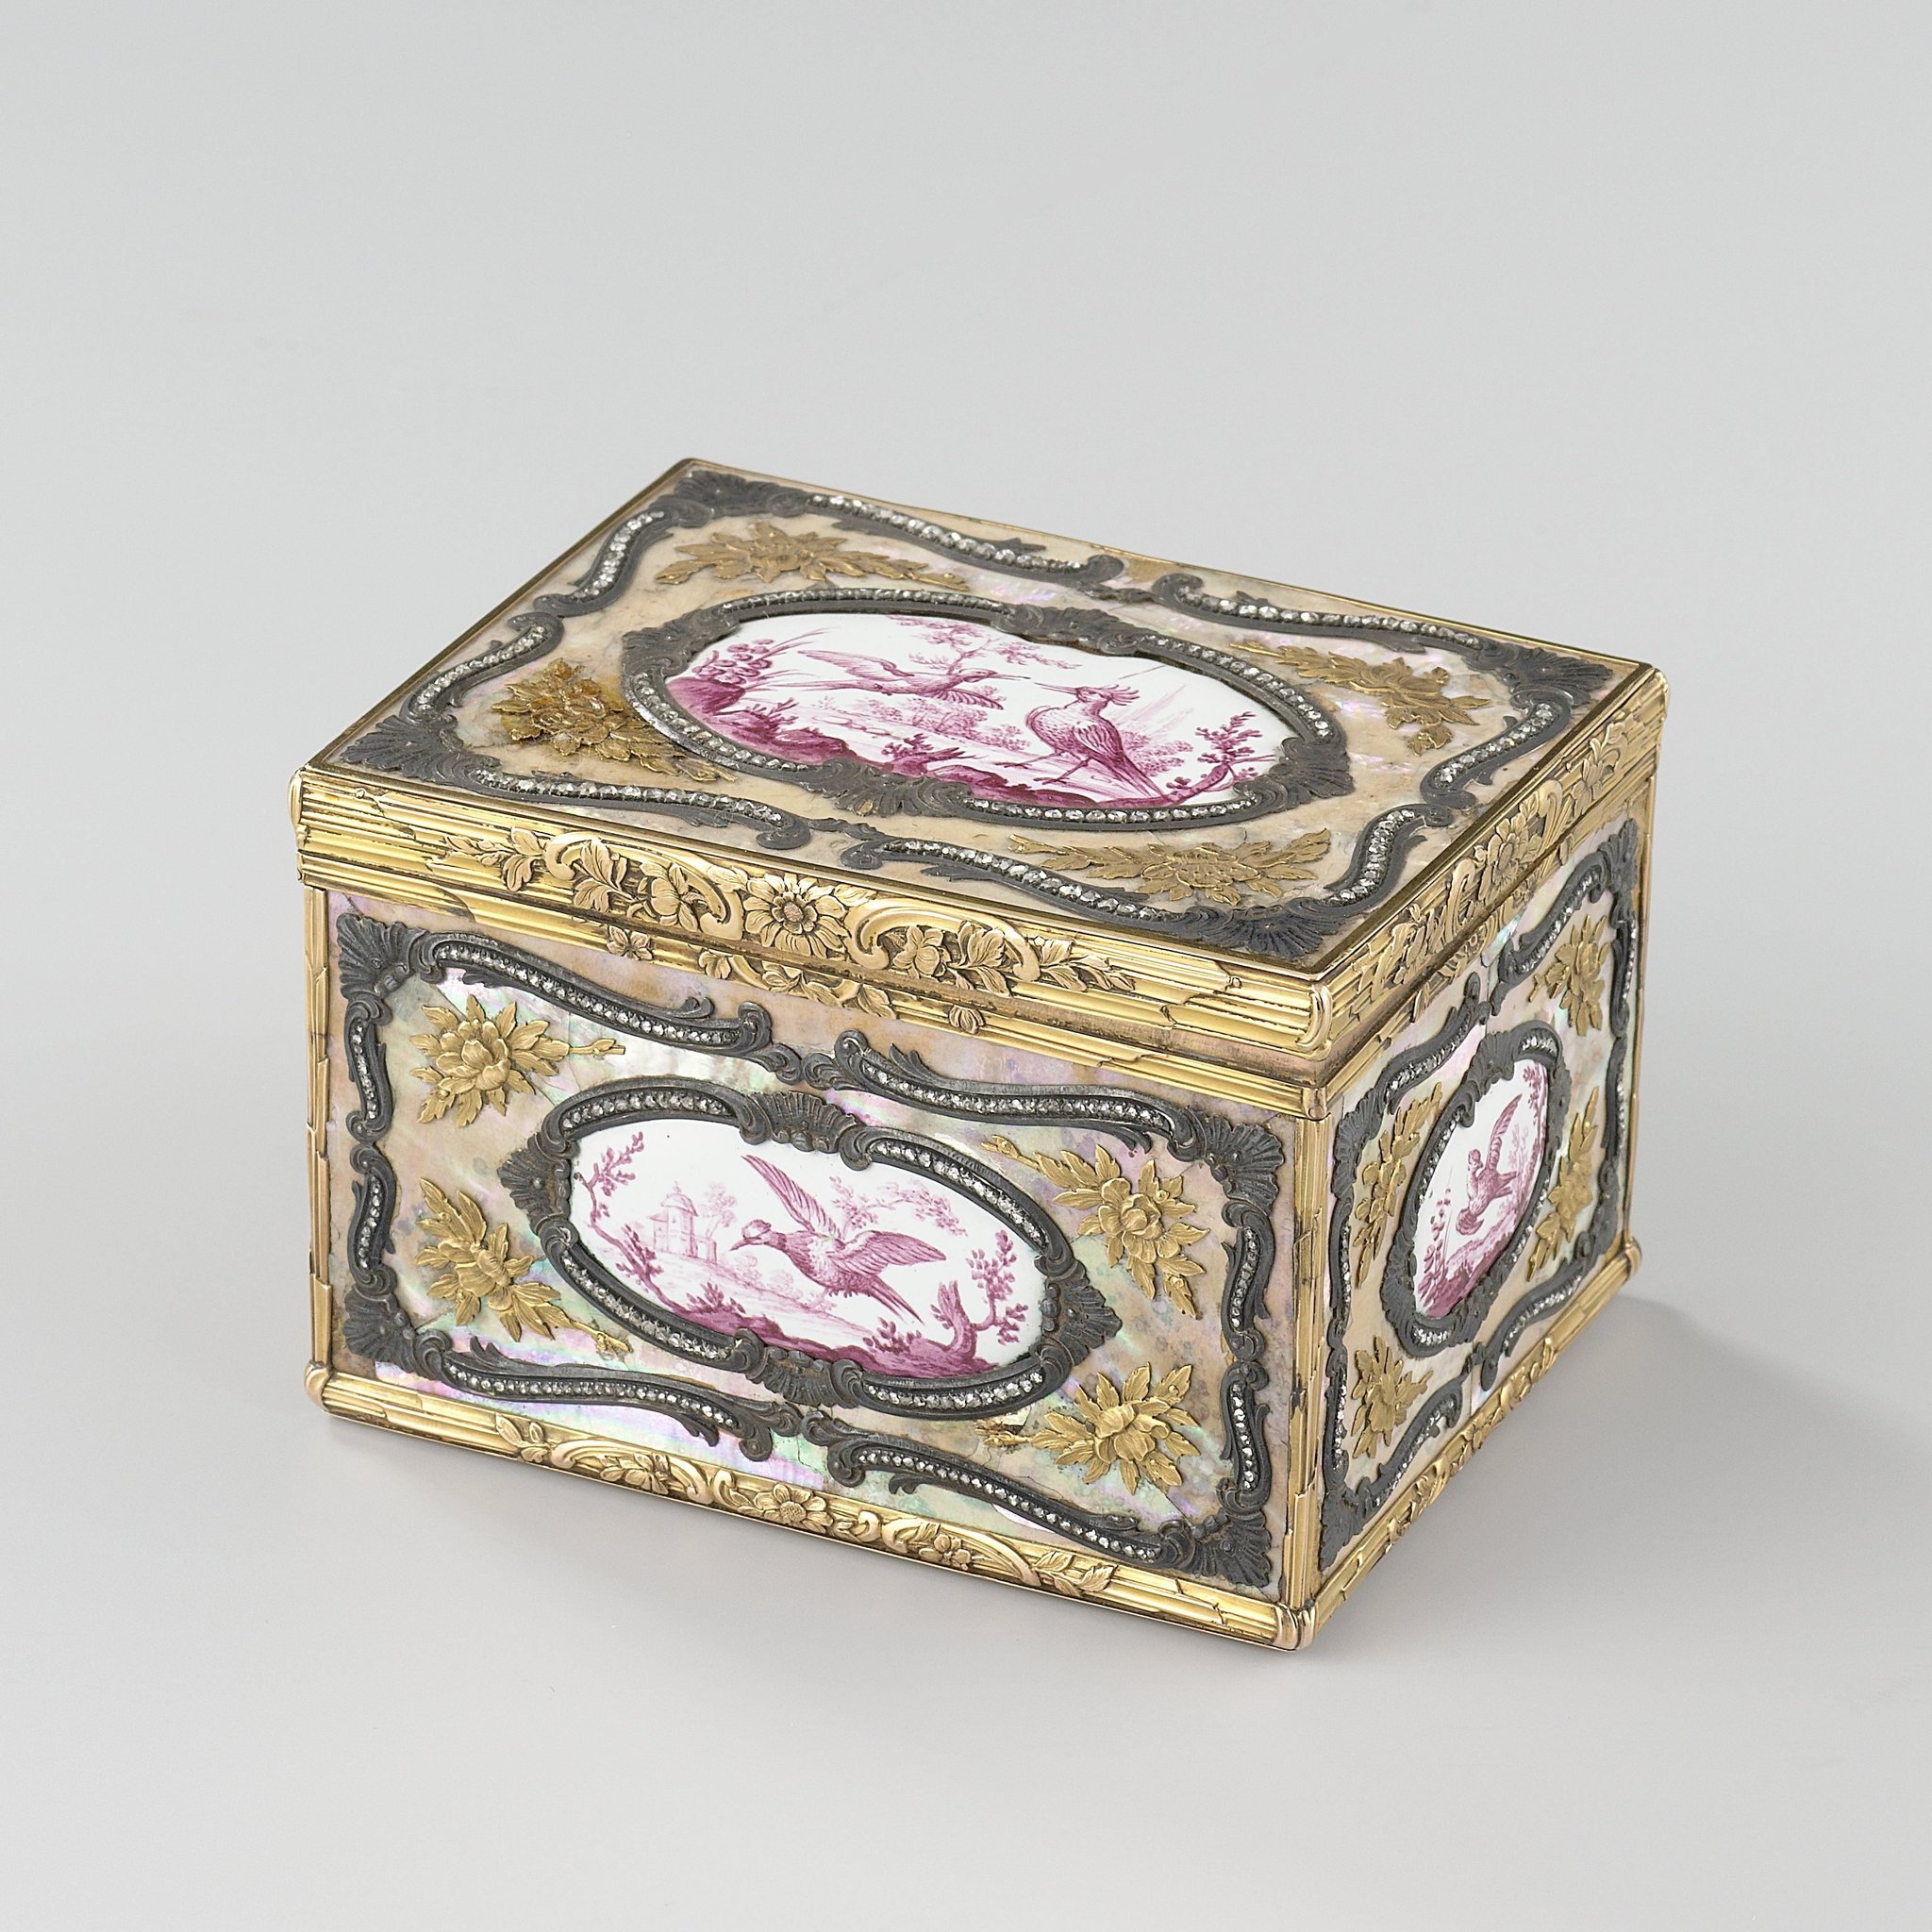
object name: box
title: Snuifdoos van goud, rechthoekig, bedekt met parelmoer, émail en diamant en versierd met vogels en voluten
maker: Anonymous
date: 1700-1800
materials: diamond, gold, mother of pearl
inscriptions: maker's mark (false): ‘GP’, mark (false), duty mark (false)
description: Snuffbox. Gold, enamel, mother-of- pearl and diamonds. Paris, 1762 - 1768, by Charles Piat.